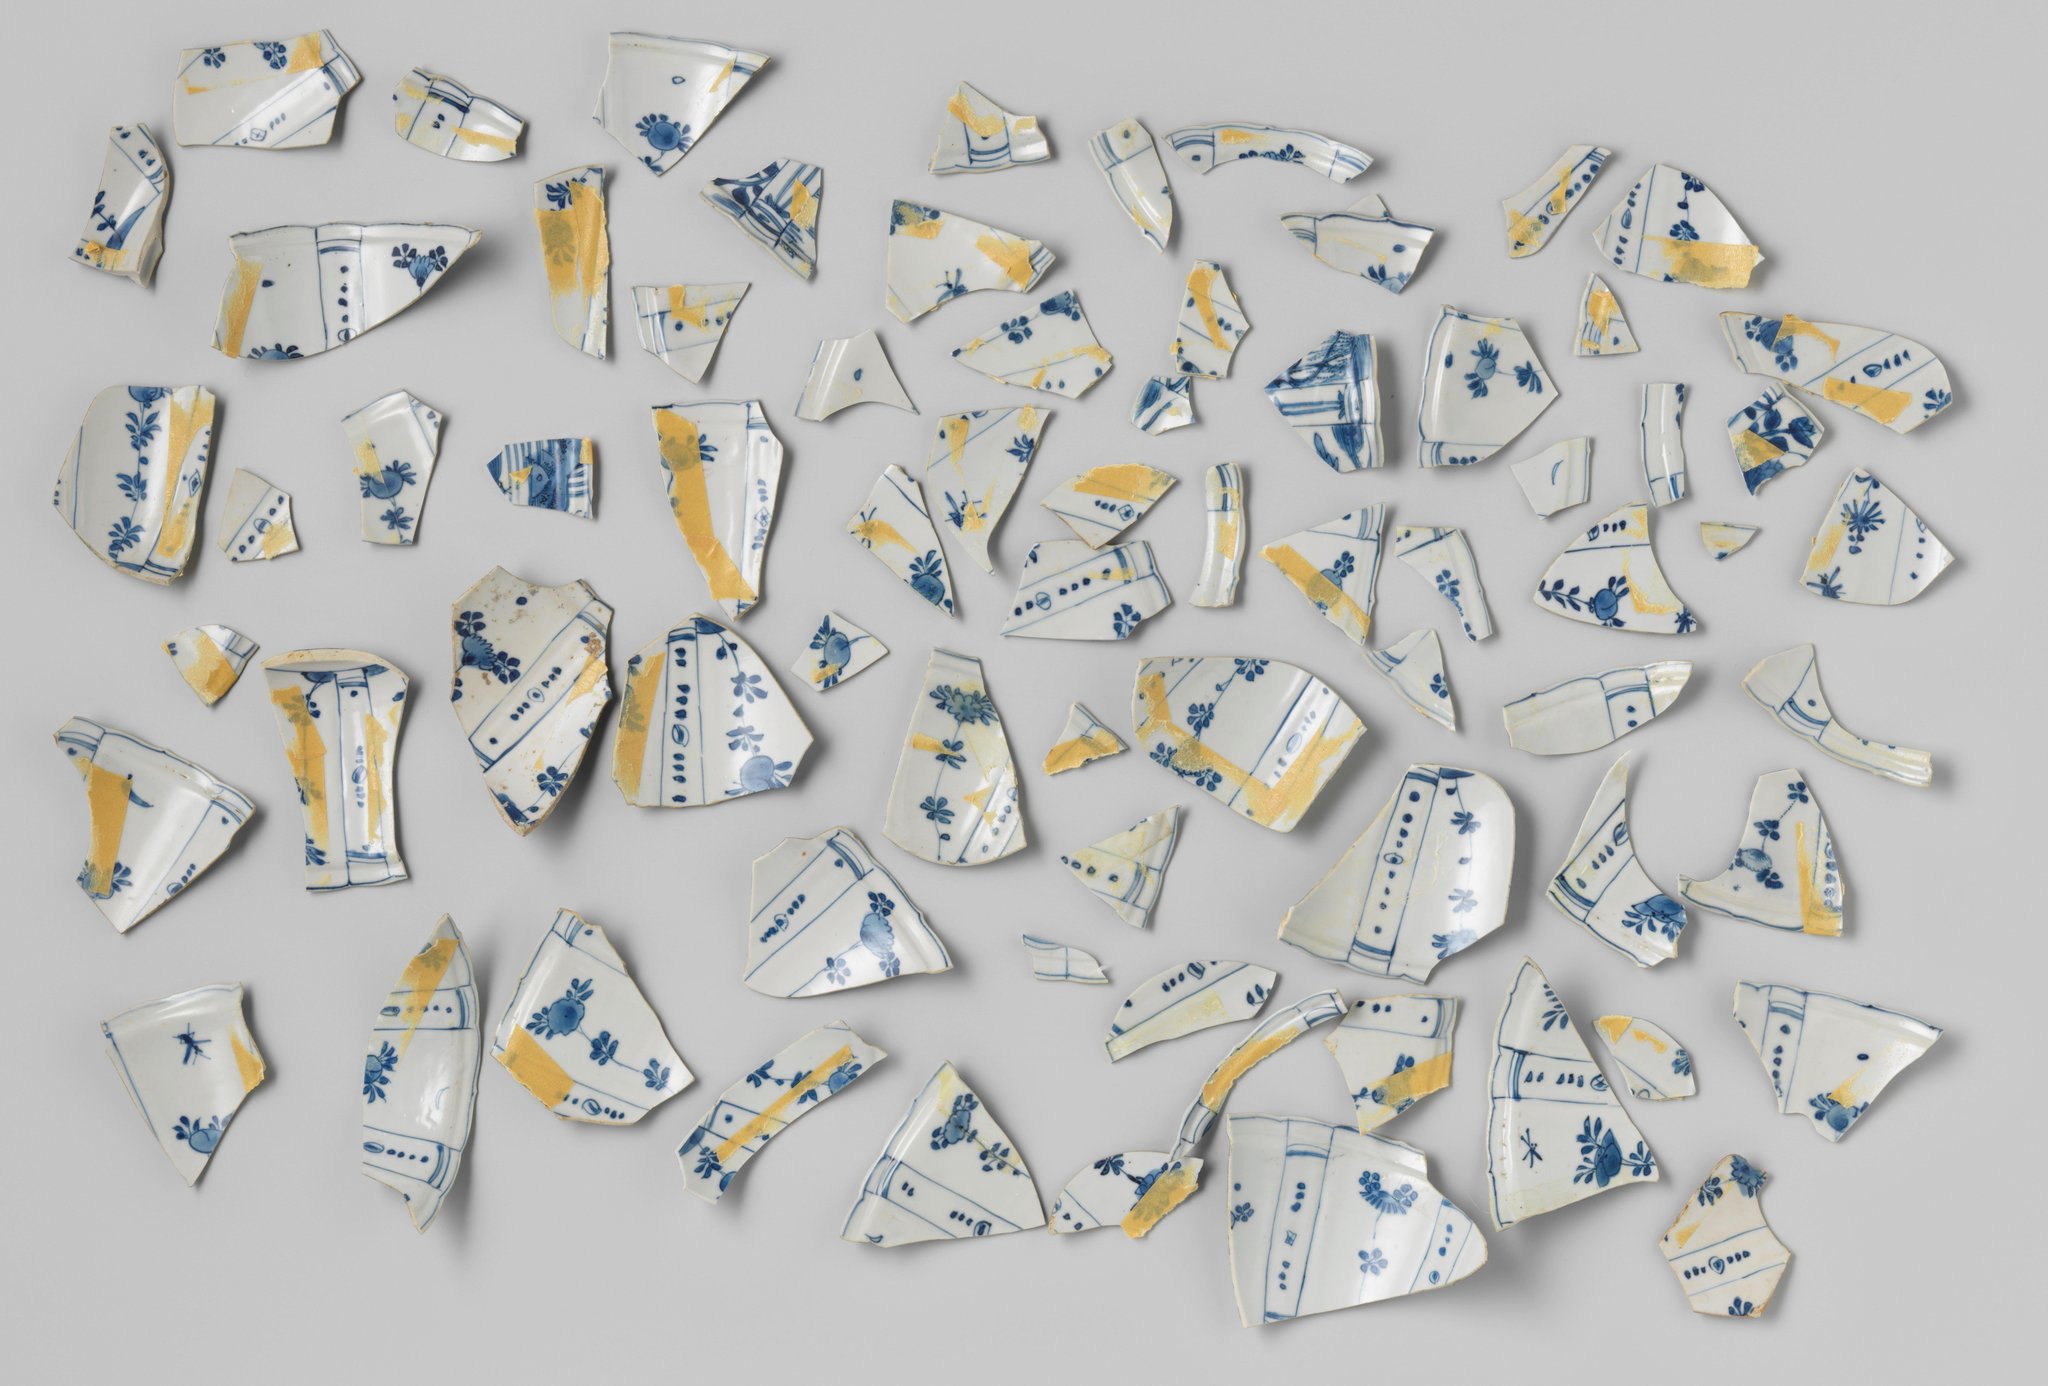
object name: kraaikop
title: Scherven van kraaikoppen uit V.O.C.-schip de 'Witte Leeuw'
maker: Anonymous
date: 1613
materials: bone china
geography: jingdezhen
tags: verenigde oostindische compagnie, sint-helena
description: Scherven van kraaikoppen uit V.O.C.-schip de 'Witte Leeuw'.